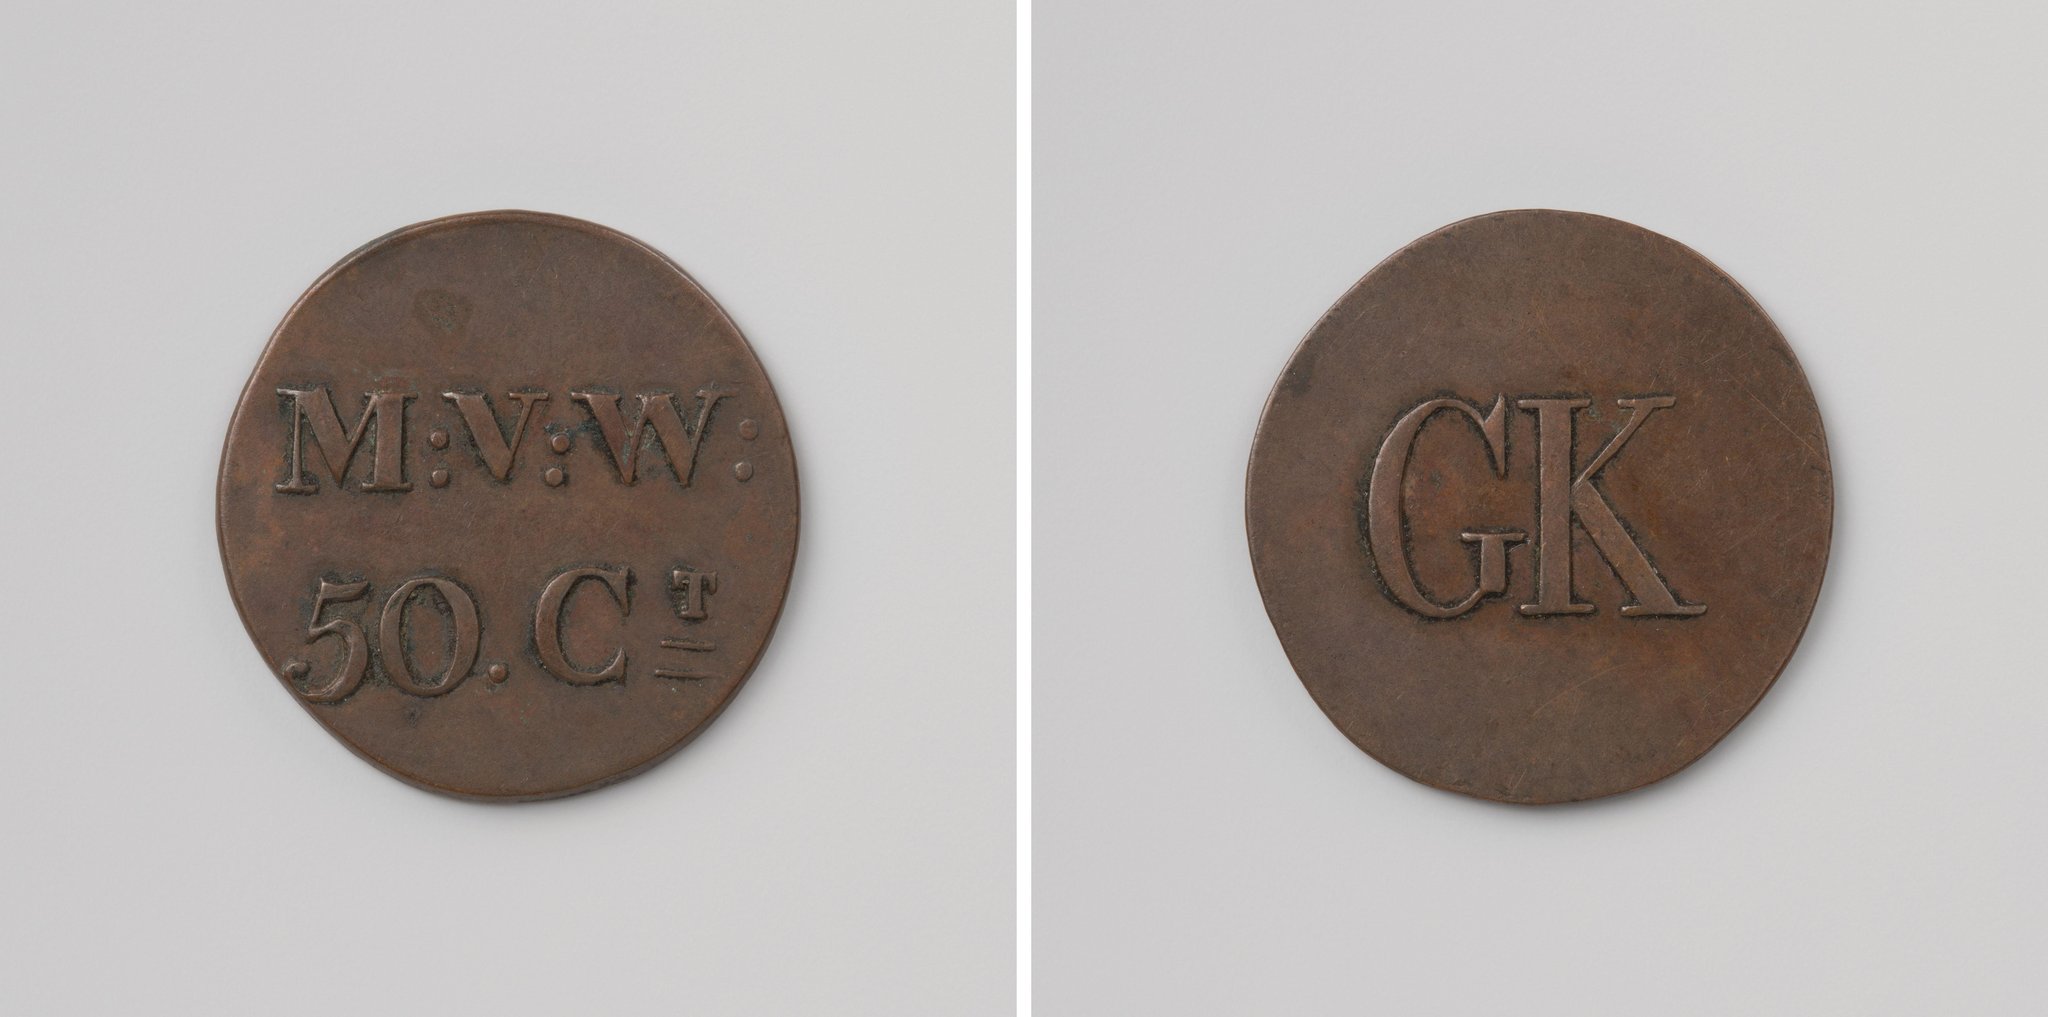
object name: huismunt prison money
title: Huismunt geslagen op last van de Maatschappij van Weldadigheid ter waarde van 50 cent, ten behoeve van de Gewone Koloniën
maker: Anonymous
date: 1818-1859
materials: copper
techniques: striking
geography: netherlands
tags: maatschappij van weldadigheid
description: Voorzijde: opschrift boven waardeaanduiding. Keerzijde: opschrift G en K